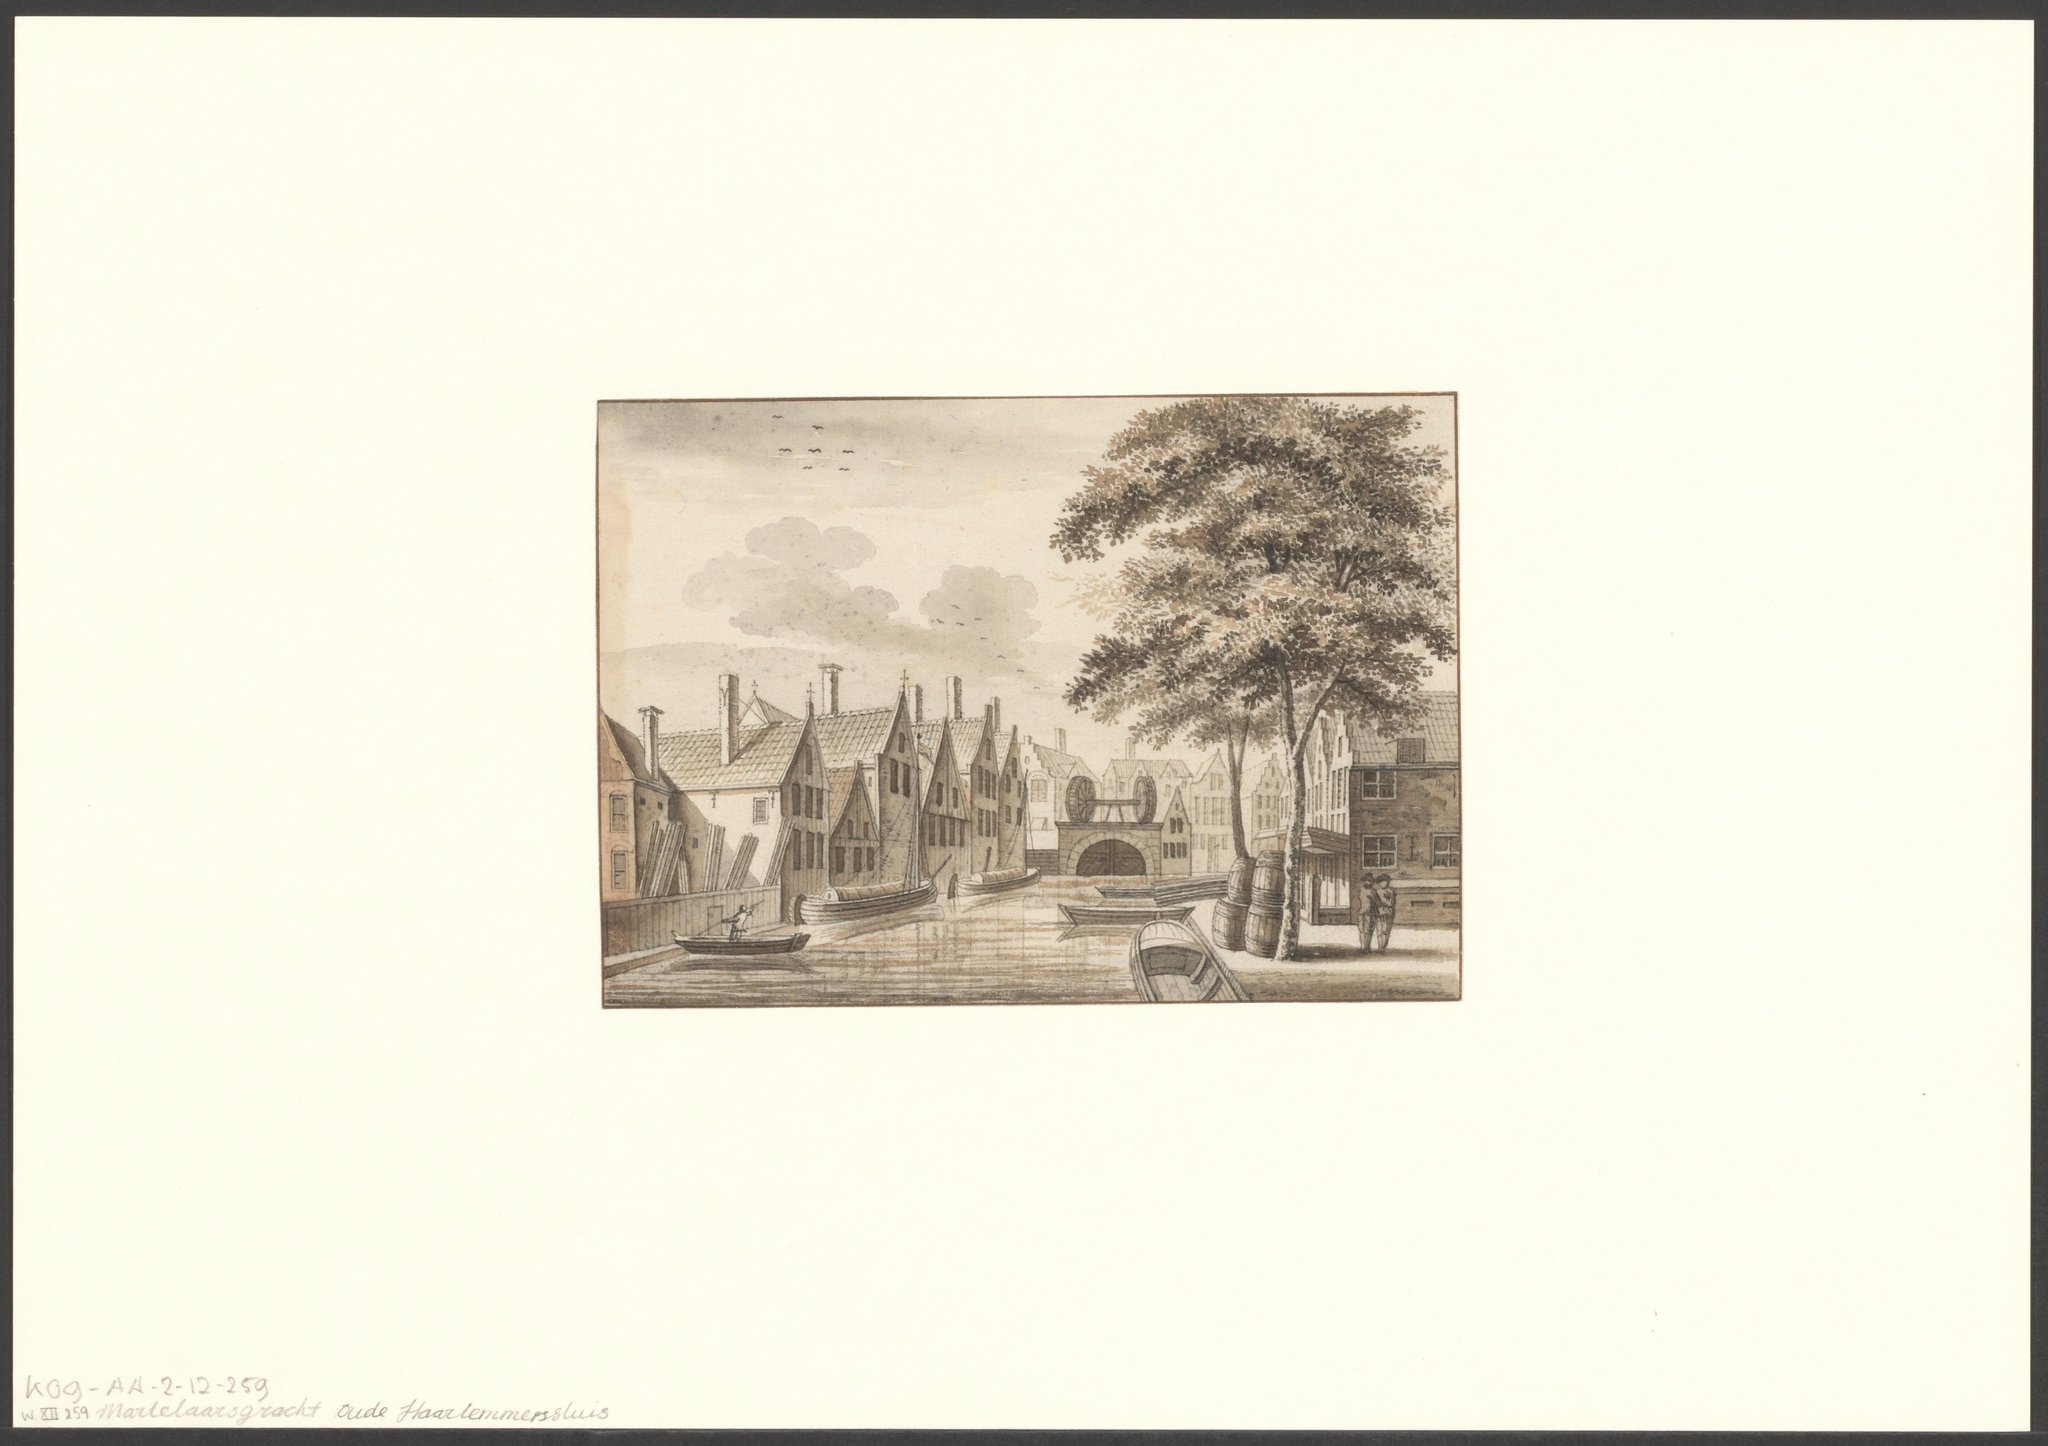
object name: drawing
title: Gezicht op de Martelaarsgracht en de Oude Haarlemmersluis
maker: Anonymous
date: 1700-1799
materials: ink, paper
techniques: brush, pen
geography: amsterdam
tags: sluice, weir, city-view, and landscape with man-made constructions, canal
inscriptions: inscription: ‘De oude Haarlemmersluis. / ov/d. martelaarsgr.’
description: Tekening binnen de Atlas Van Eck ingedeeld op wijknummer 12.